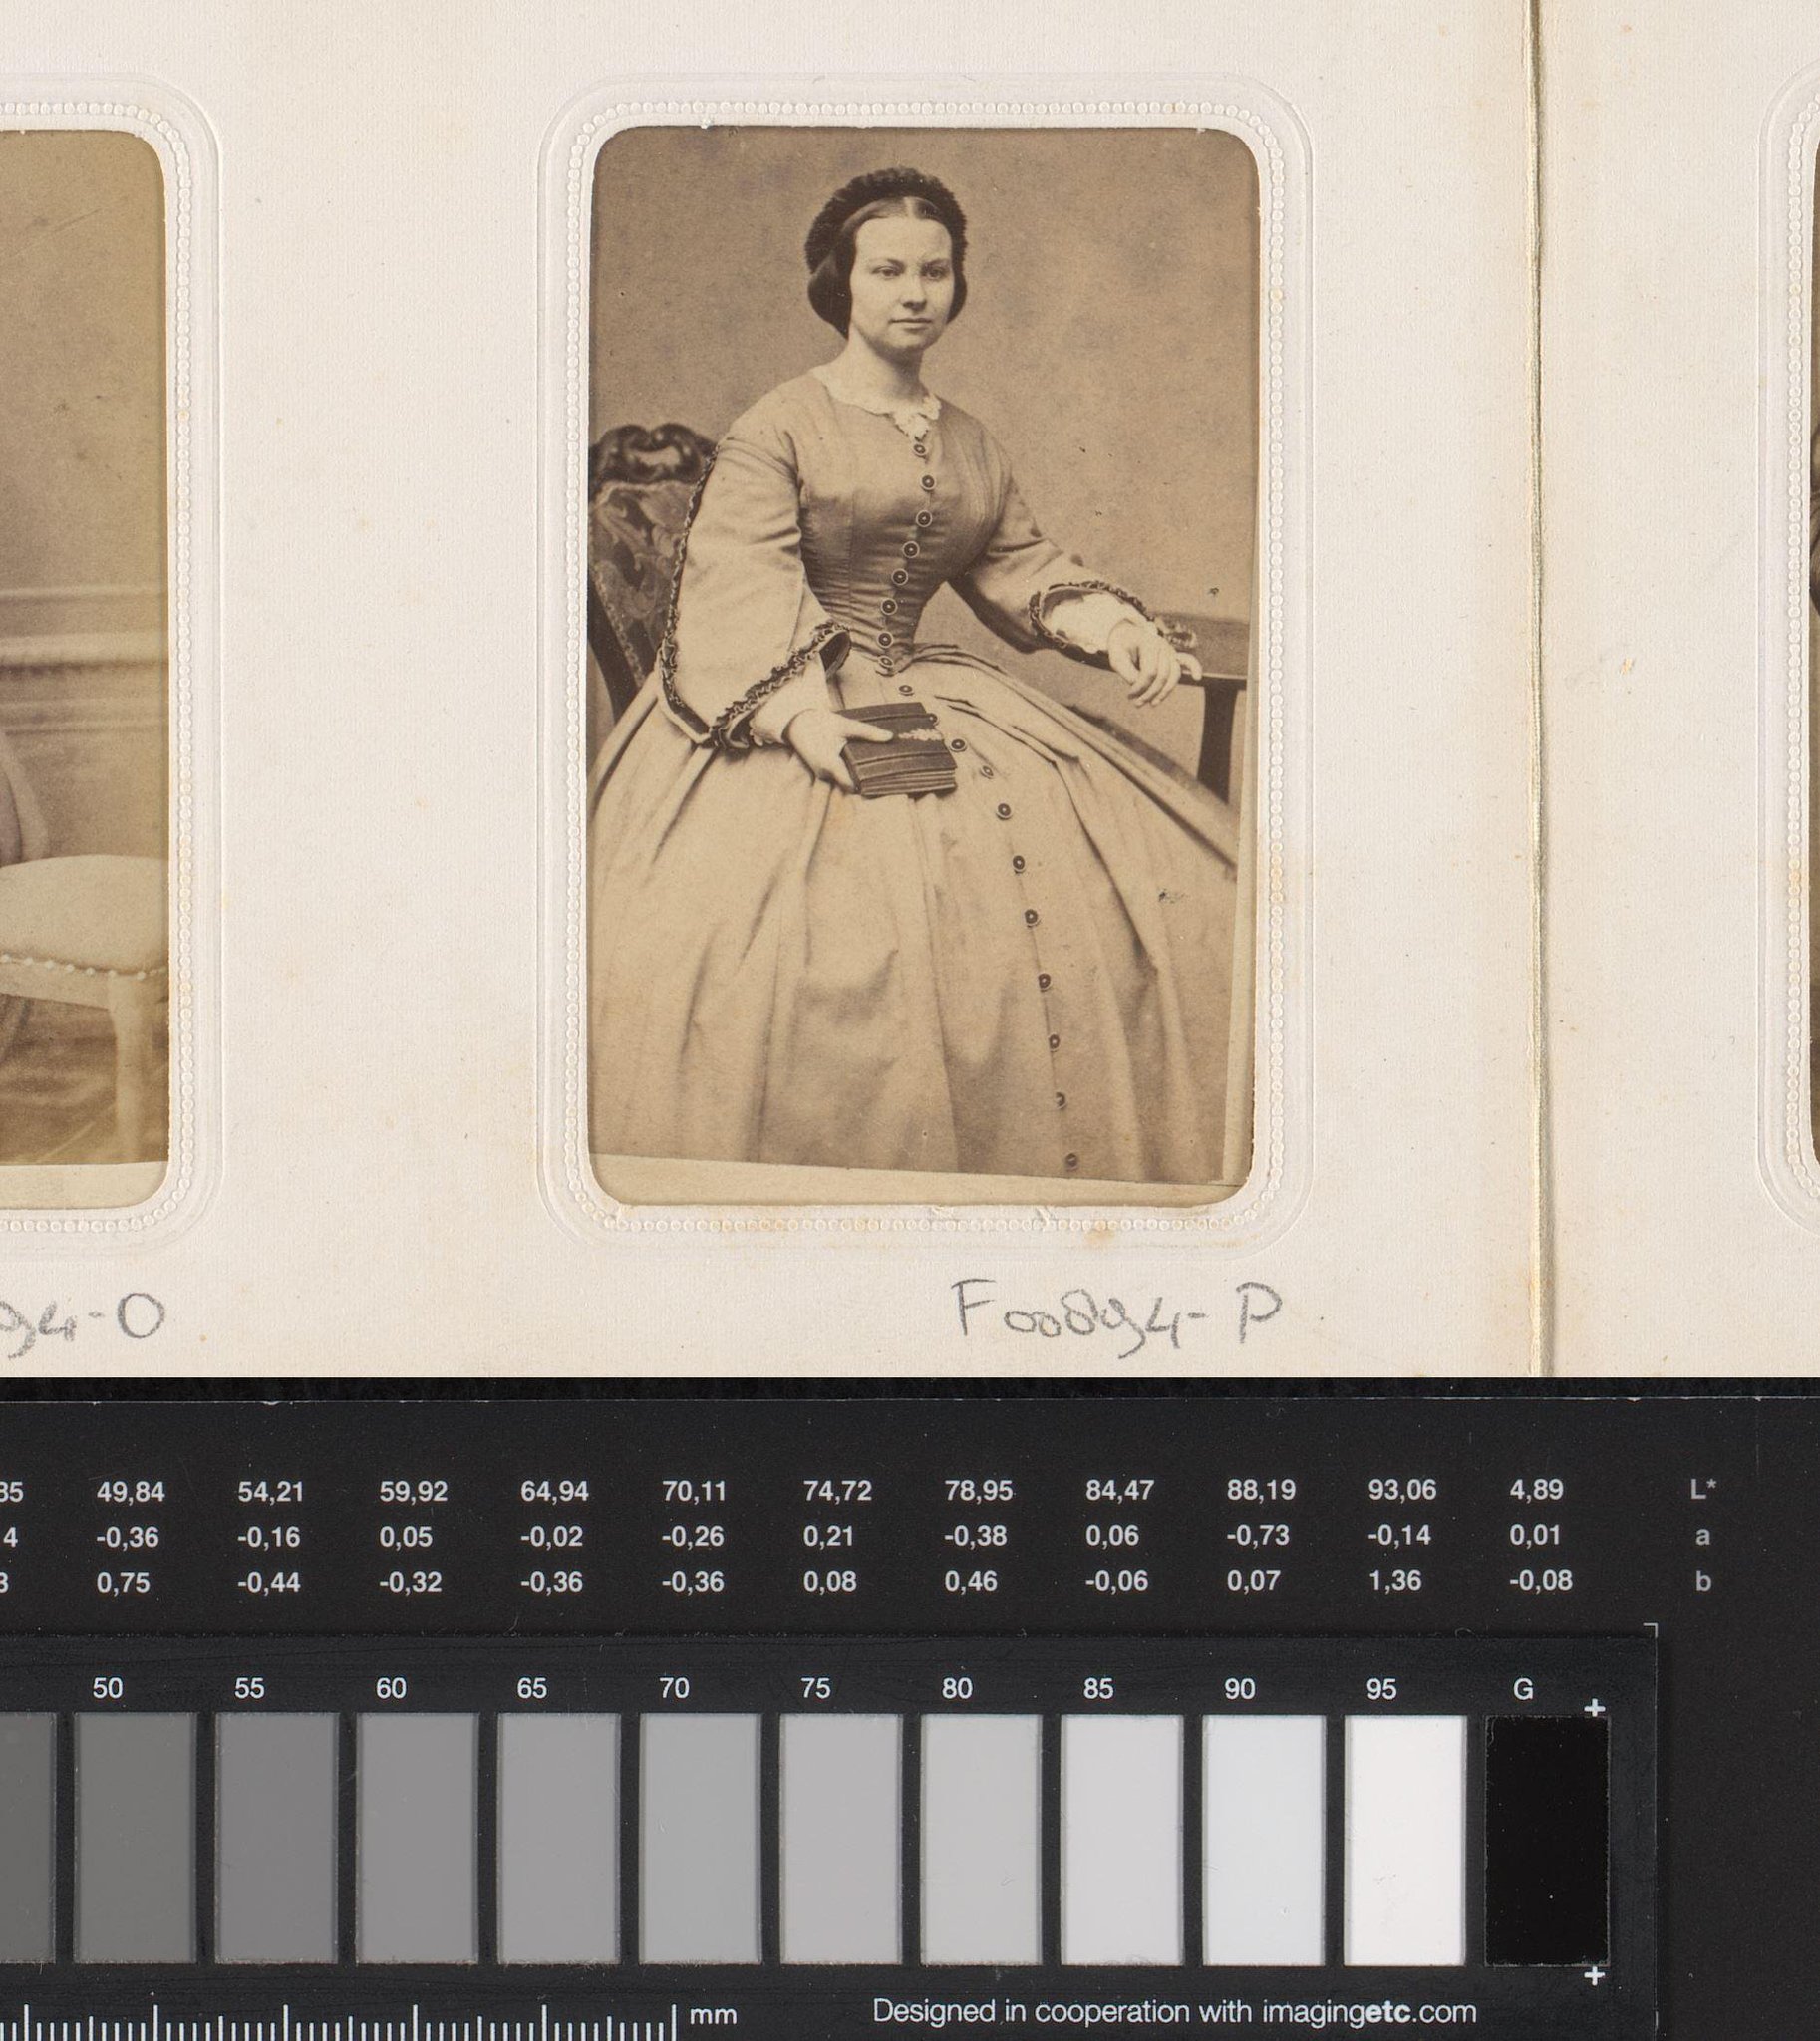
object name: photograph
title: Portret van een zittende jonge vrouw met boek in de hand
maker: willem tinker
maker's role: fotograaf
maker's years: 1816-1894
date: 1860-1880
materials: cardboard, photographic support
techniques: albumen print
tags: adolescent, young woman, maiden, historical persons, book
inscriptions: inscription: ‘W. Tinker/ Photograaph/ Haarlem’